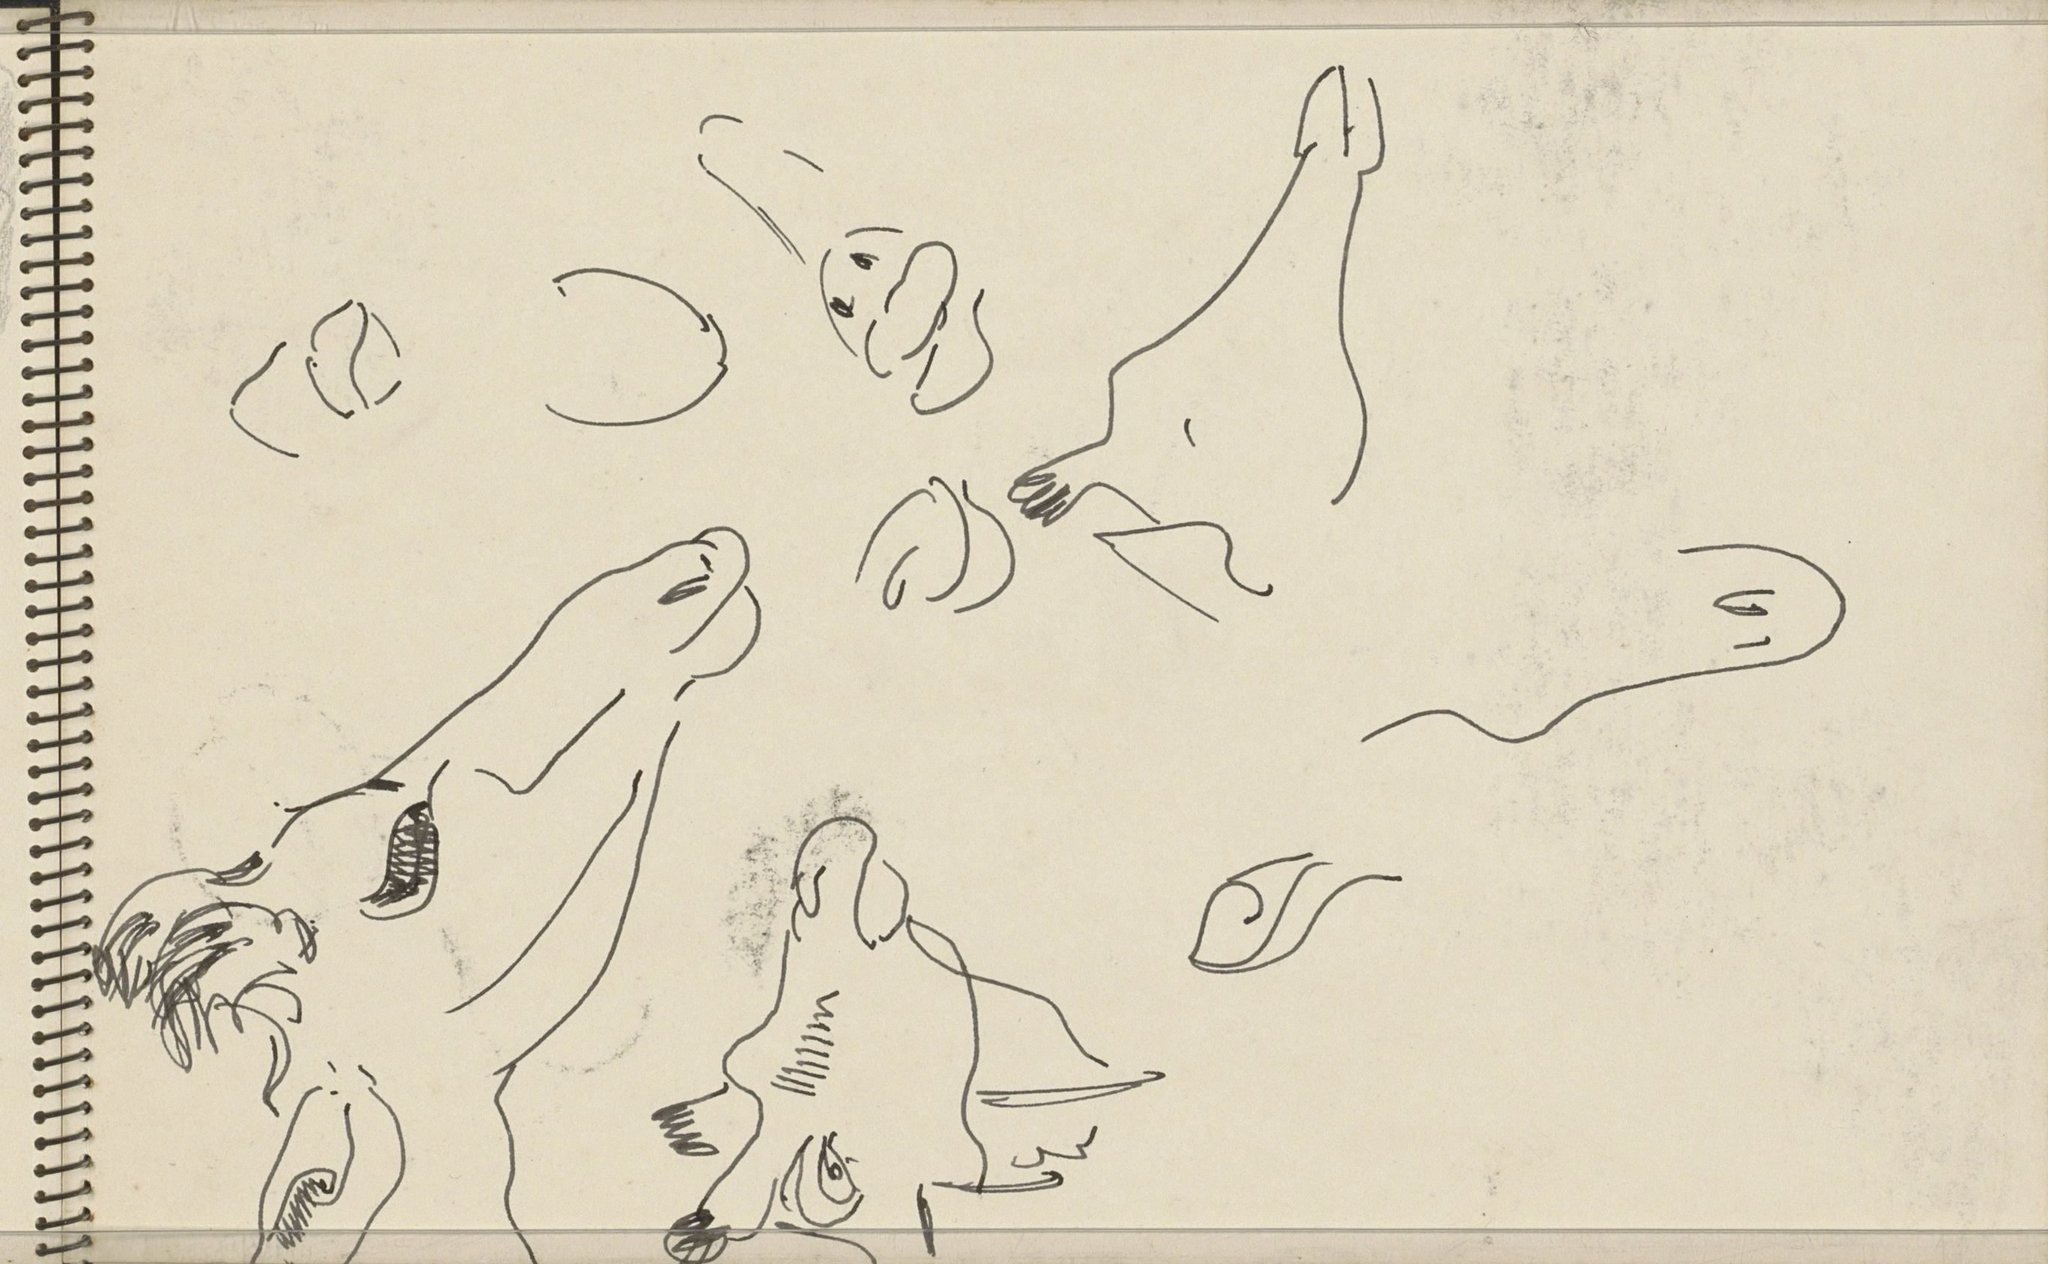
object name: sketchbook leaf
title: Koppen en snuiten van giraffen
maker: carel adolph lion cachet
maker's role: draughtsman, print maker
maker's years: 1864-1945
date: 1930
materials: ink, paper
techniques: pen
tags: hoofed animals: giraffe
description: Blad 11 recto uit een schetsboek met 14 bladen.